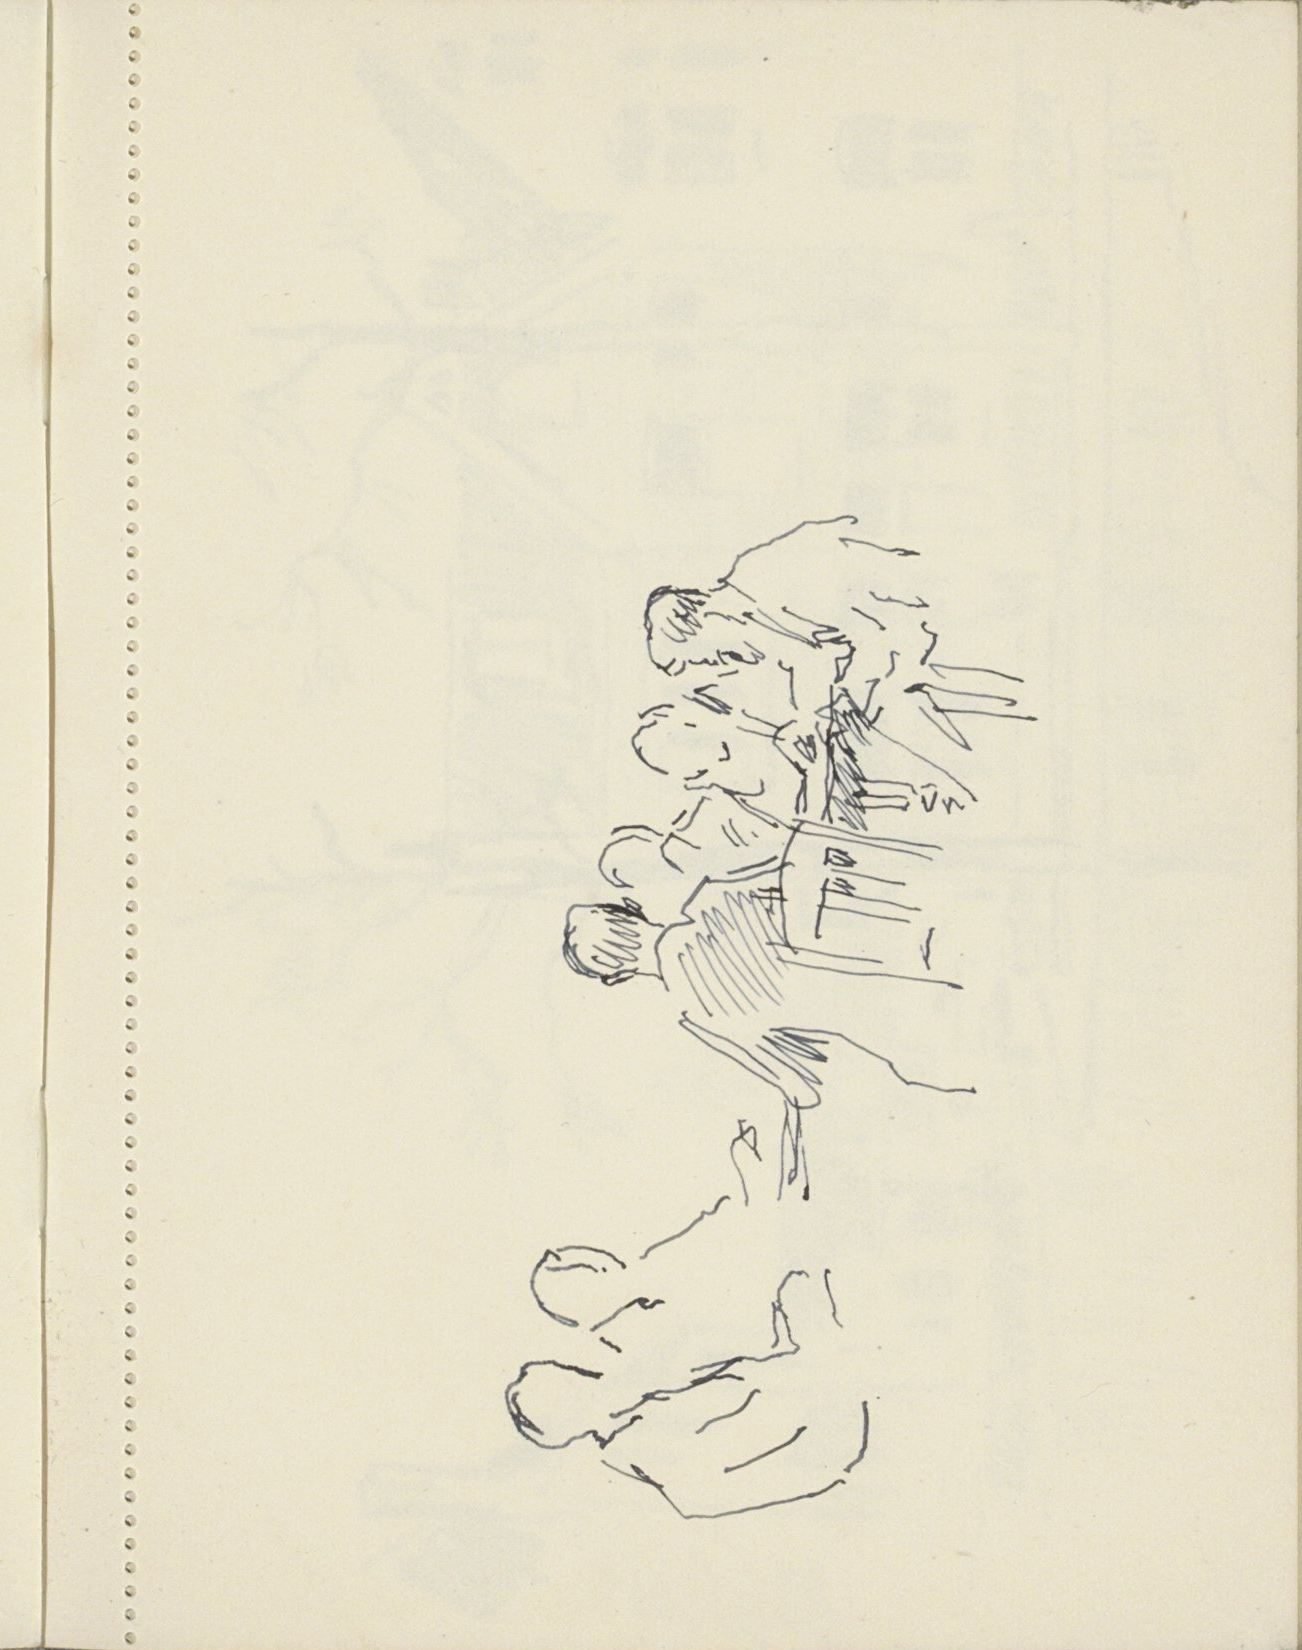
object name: sketchbook leaf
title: Zes figuren zittend aan een tafel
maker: cornelis vreedenburgh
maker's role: draughtsman, print maker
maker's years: 1880-1946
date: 1890-1946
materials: ink, paper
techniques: pen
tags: sitting figure, table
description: Blad 42 recto uit een schetsboek met 71 bladen.